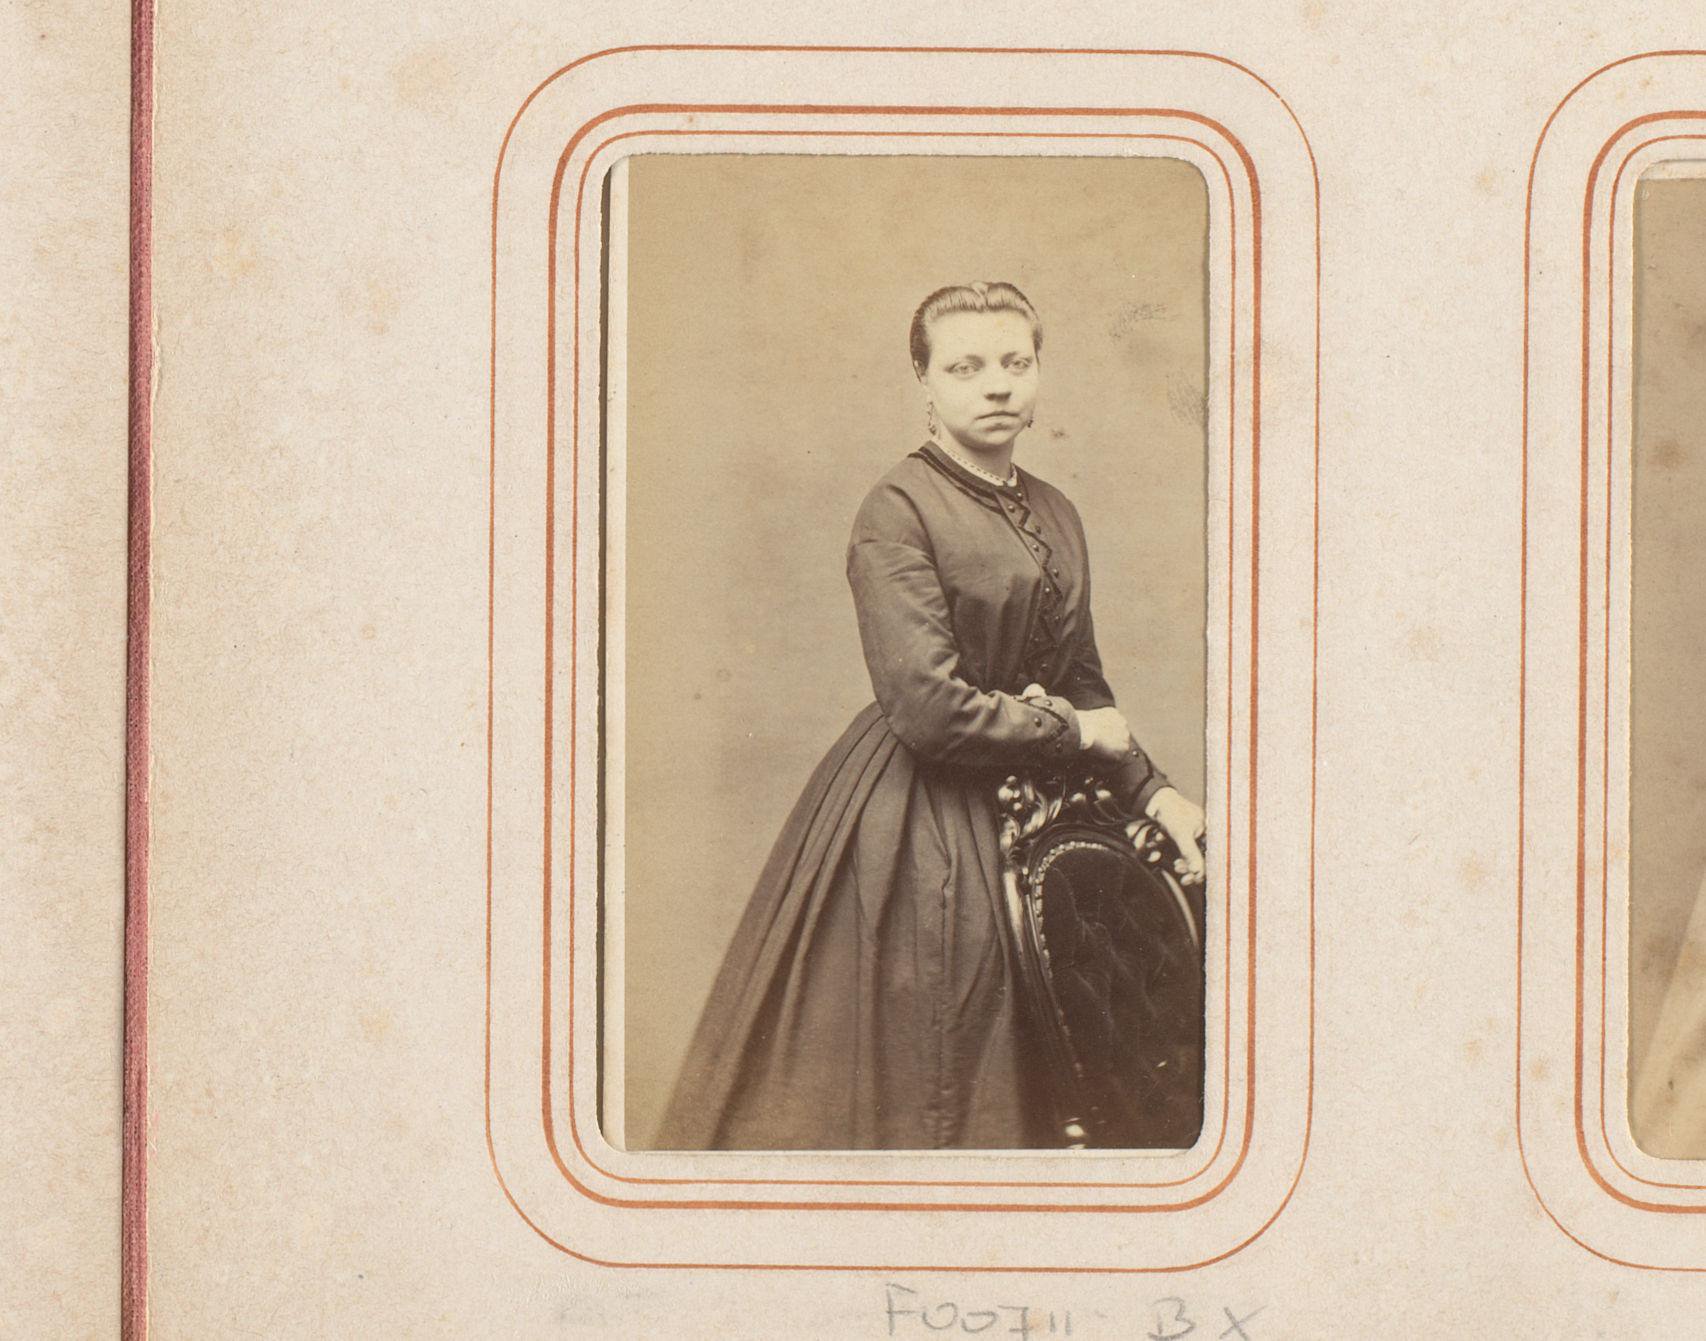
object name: album leaf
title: Portret van een staande vrouw bij een stoel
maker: albert greiner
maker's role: fotograaf, fotostudio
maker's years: 1833-1890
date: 1861-1874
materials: cardboard, photographic support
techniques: albumen print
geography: amsterdam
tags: historical persons - bb - woman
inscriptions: inscription: ‘A. Greiner/ Photograf/ Nieuwendijk L.87/ Amsterdam’